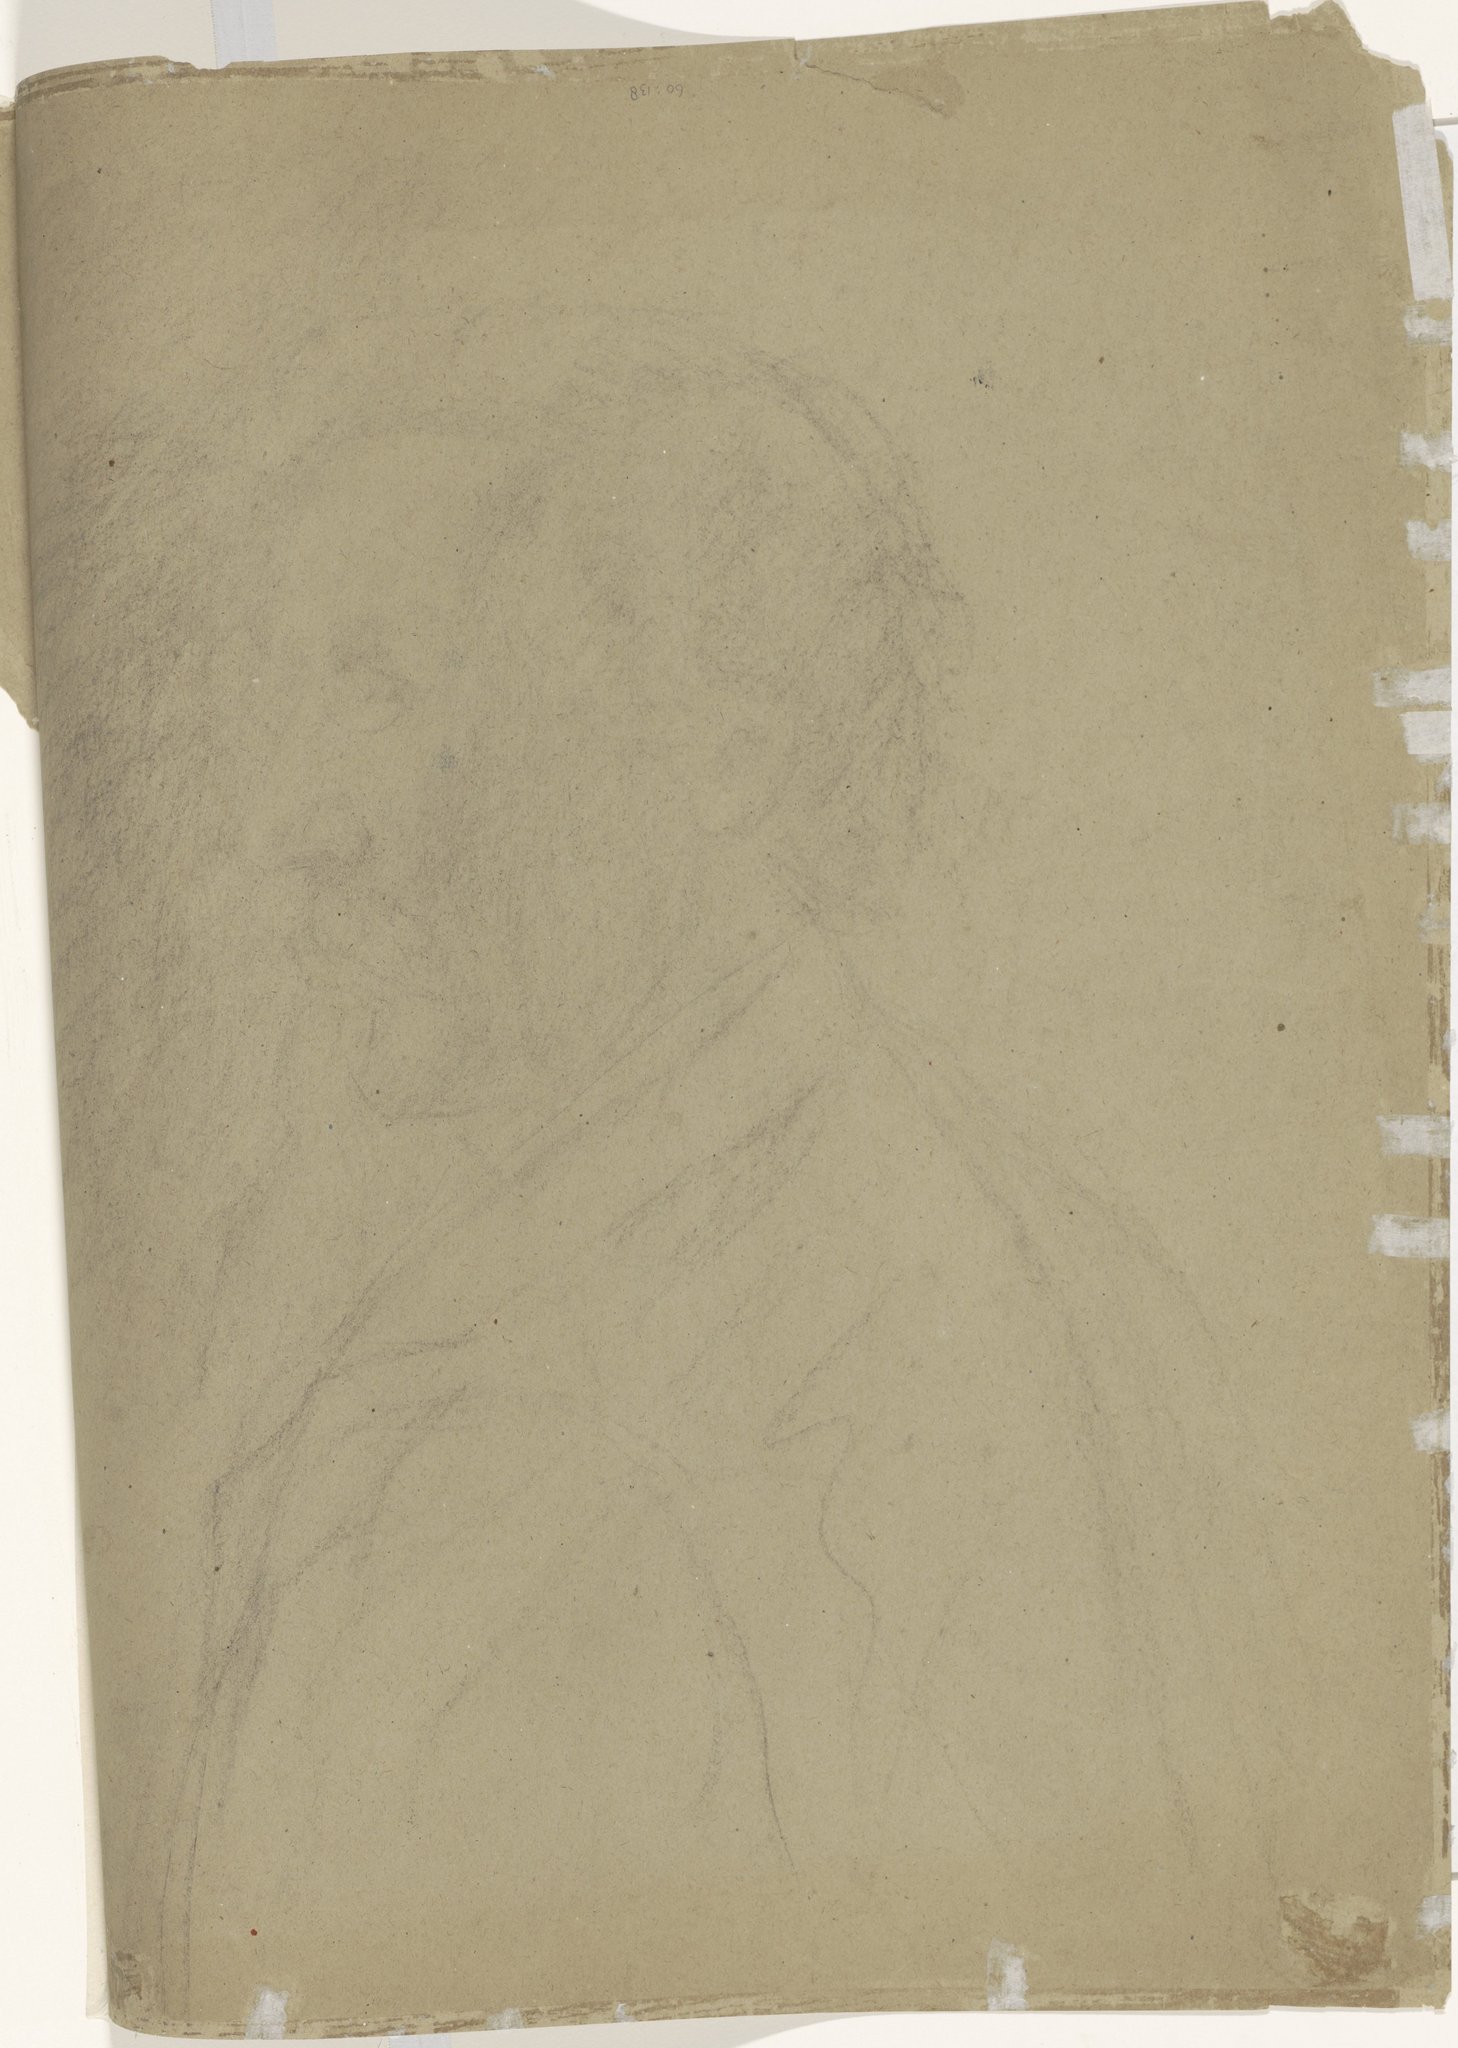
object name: drawing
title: Schets van een man met baard en profiel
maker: thérèse schwartze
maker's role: draughtsman, painter, print maker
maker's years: 1851-1918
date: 1861-1918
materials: chalk, paper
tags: anonymous historical person portrayed alone